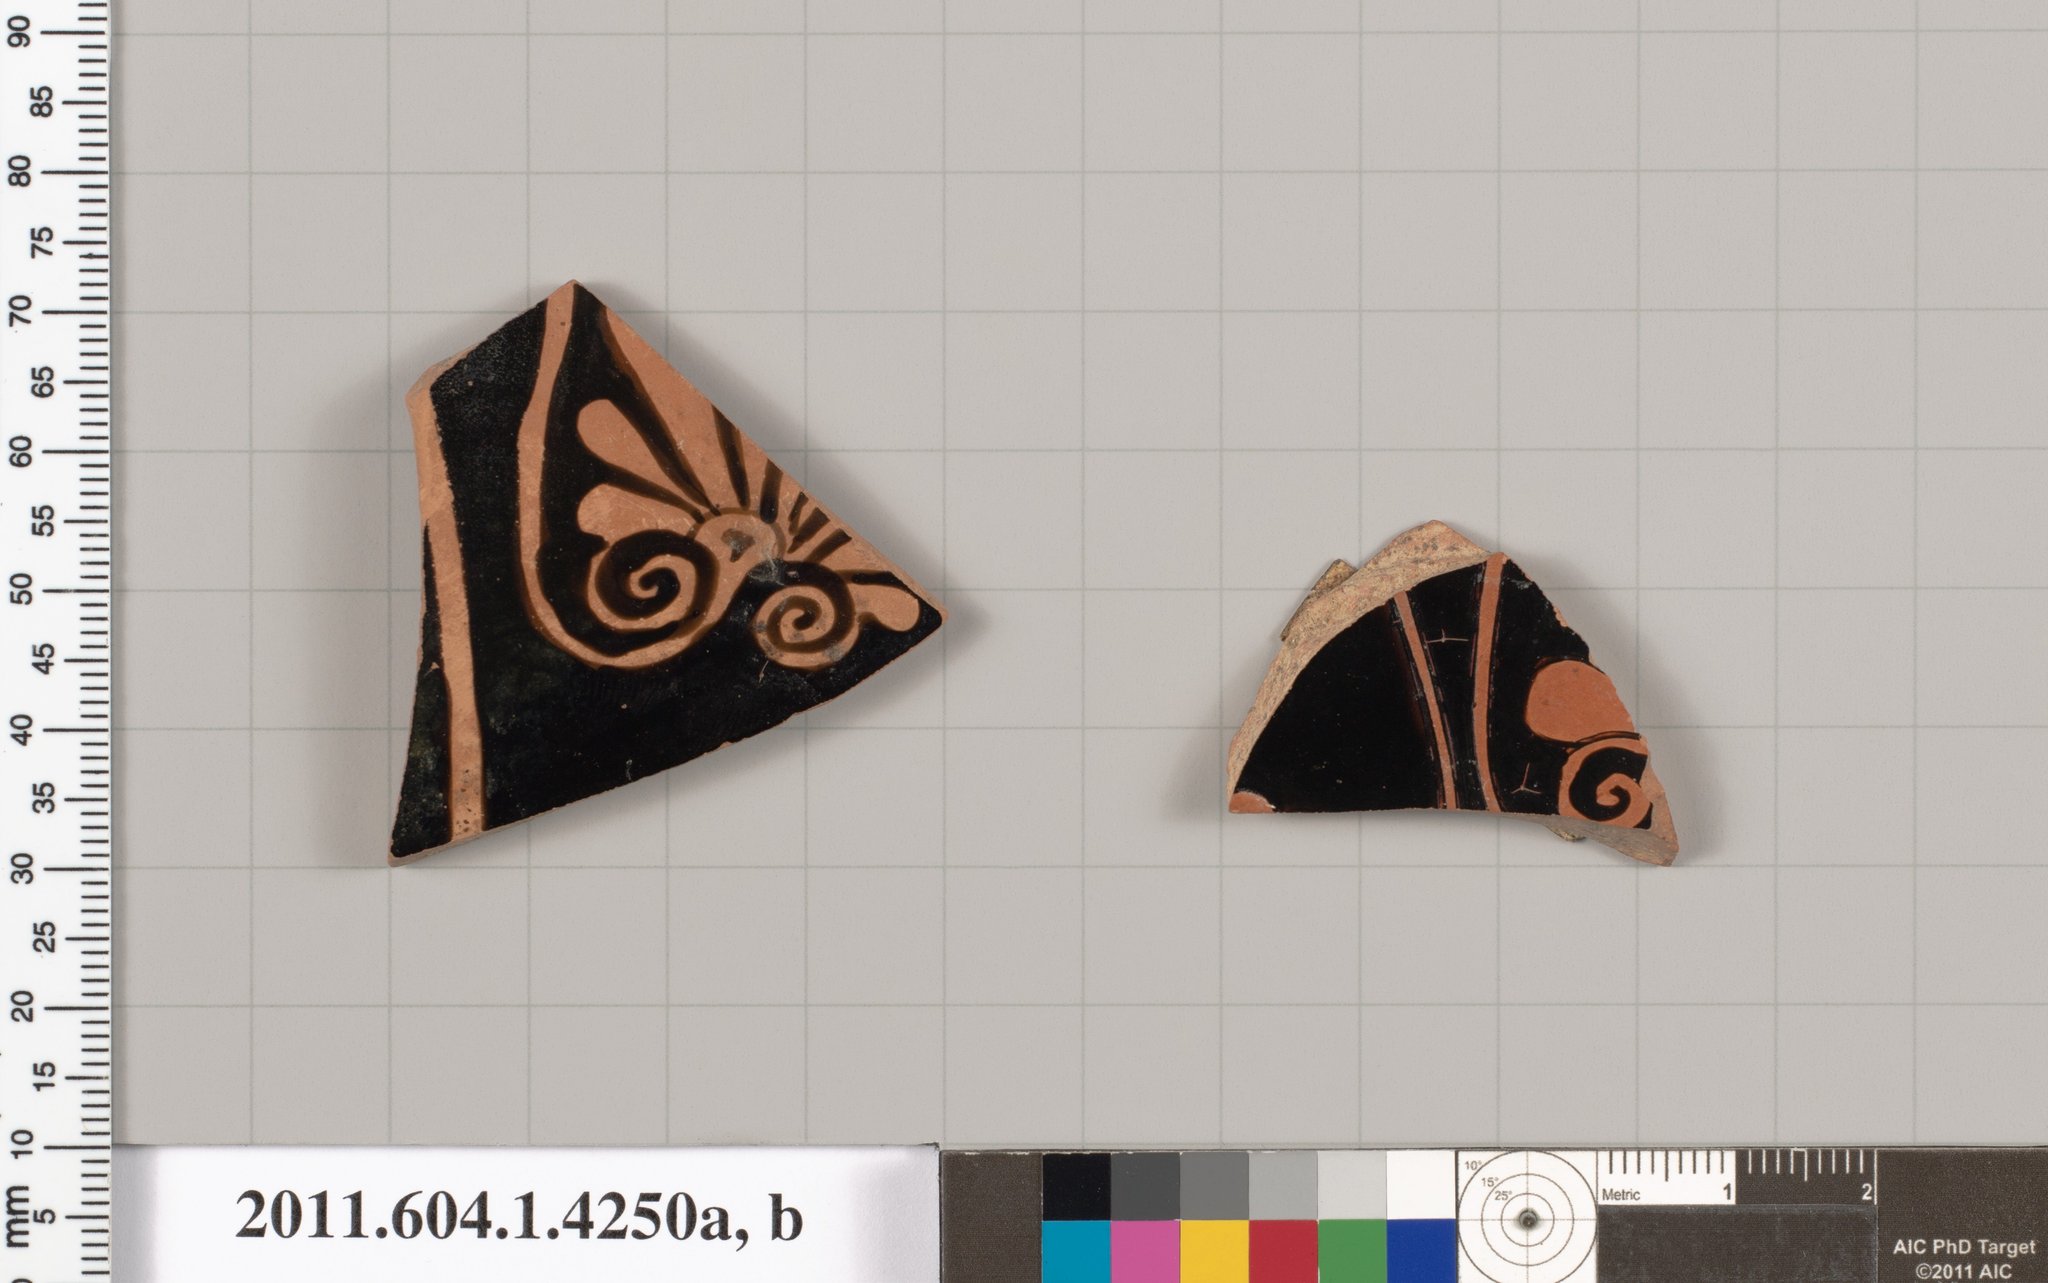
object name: kylix fragment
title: Terracotta fragments of kylikes (drinking cups)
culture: greek, attic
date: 500-451 BCE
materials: terracotta